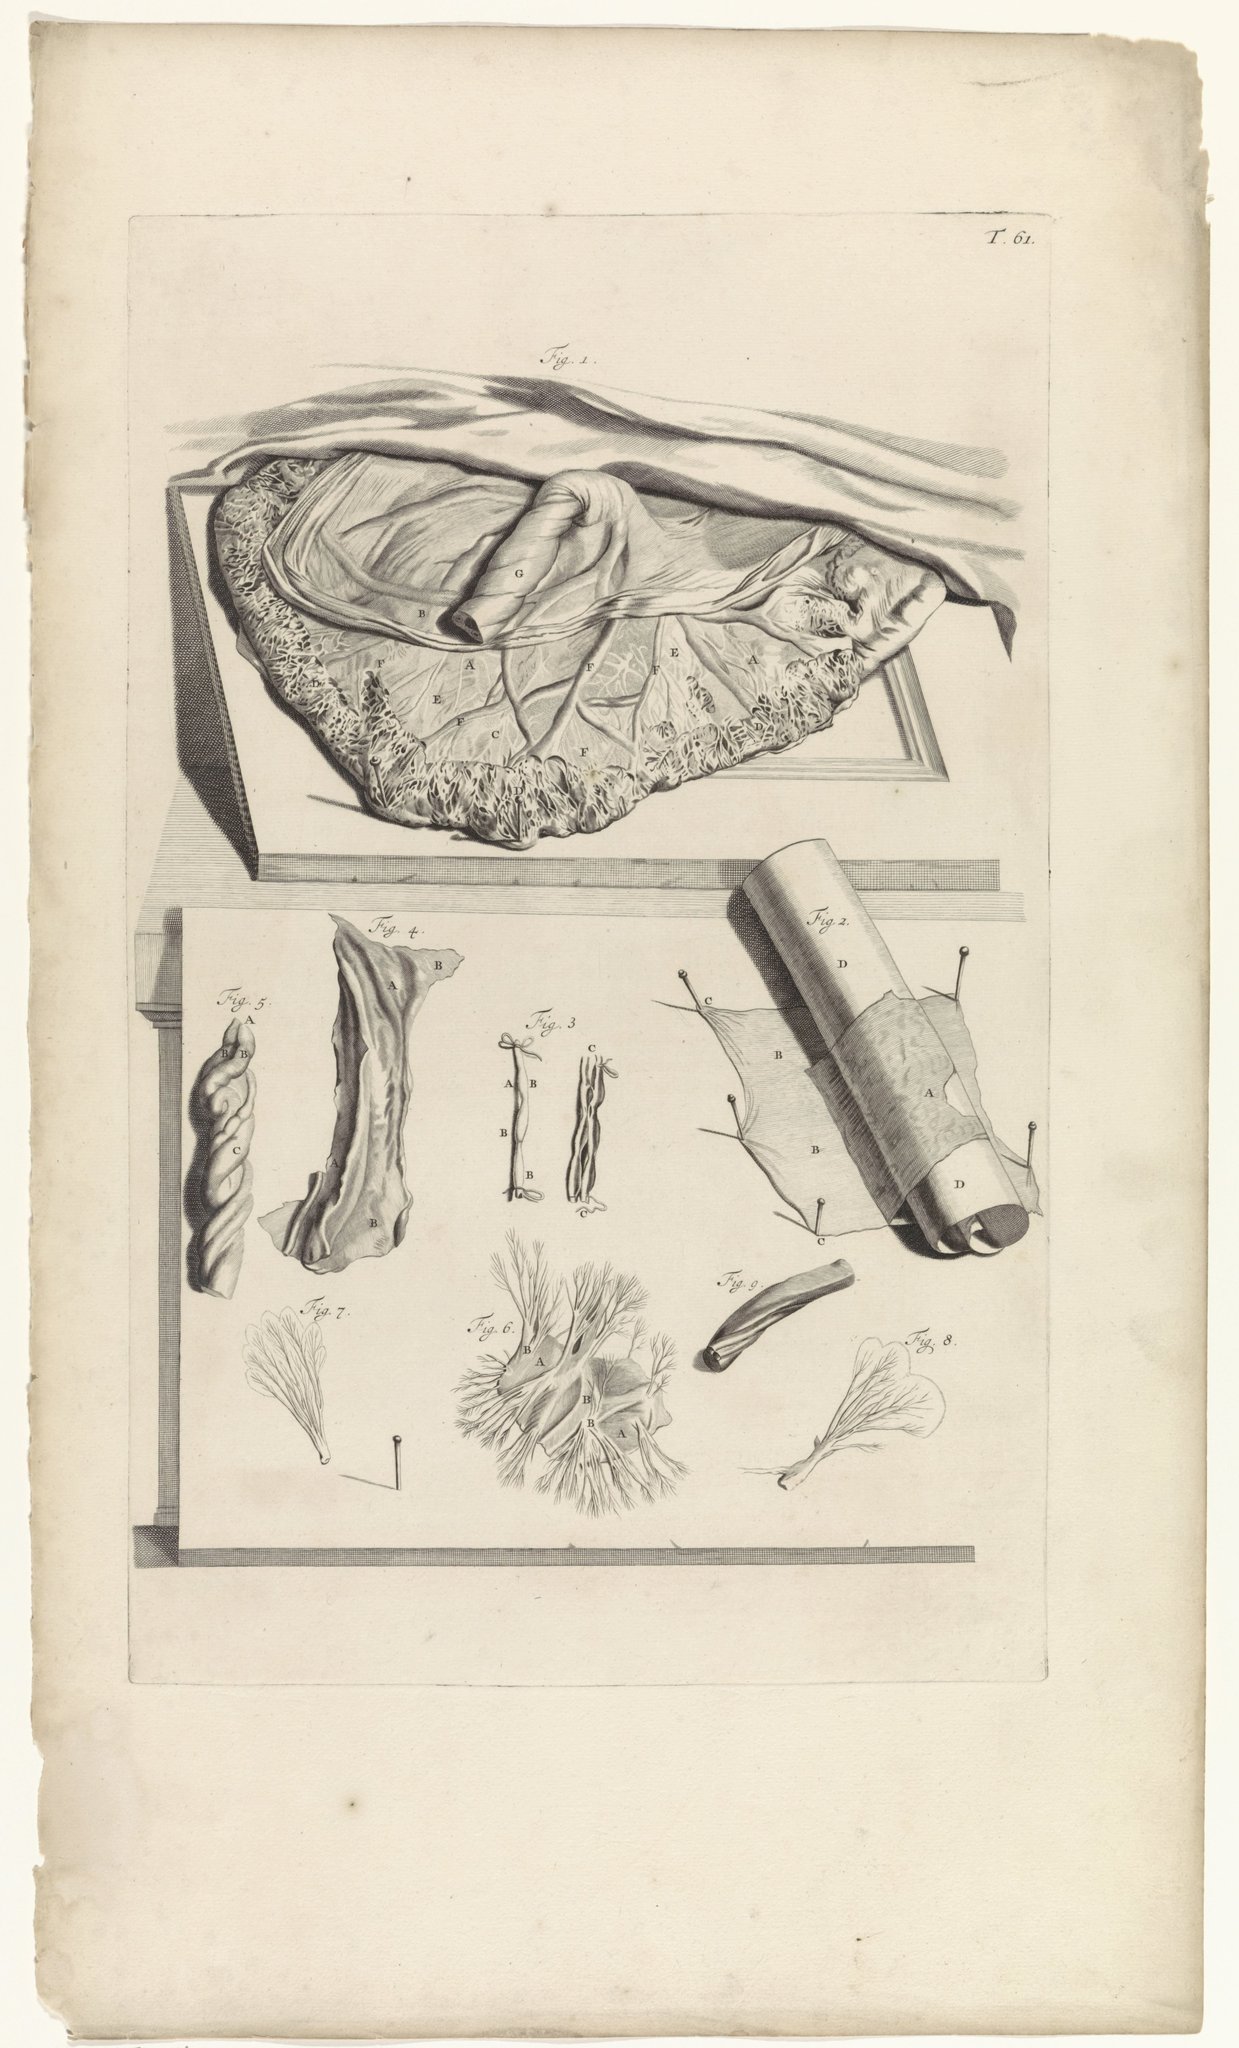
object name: book illustration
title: Anatomische studie van delen van de placenta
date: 1685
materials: paper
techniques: engraving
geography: amsterdam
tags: placenta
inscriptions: collector's mark: Lugt 2228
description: Boekillustratie voor Bidloo, Godefridus. Anatomia humani corporis centum & quinque tabulis, per art. G. de Lairesse ad vivum delineatis, de monstrata, veterum recentiorumque inventis explicata plurimisque, hactenus non detectis, illustrata. Amsterdam: Weduwe Joannes van Someren, Hendrick Boom en erven Dirk Boom, 1685.